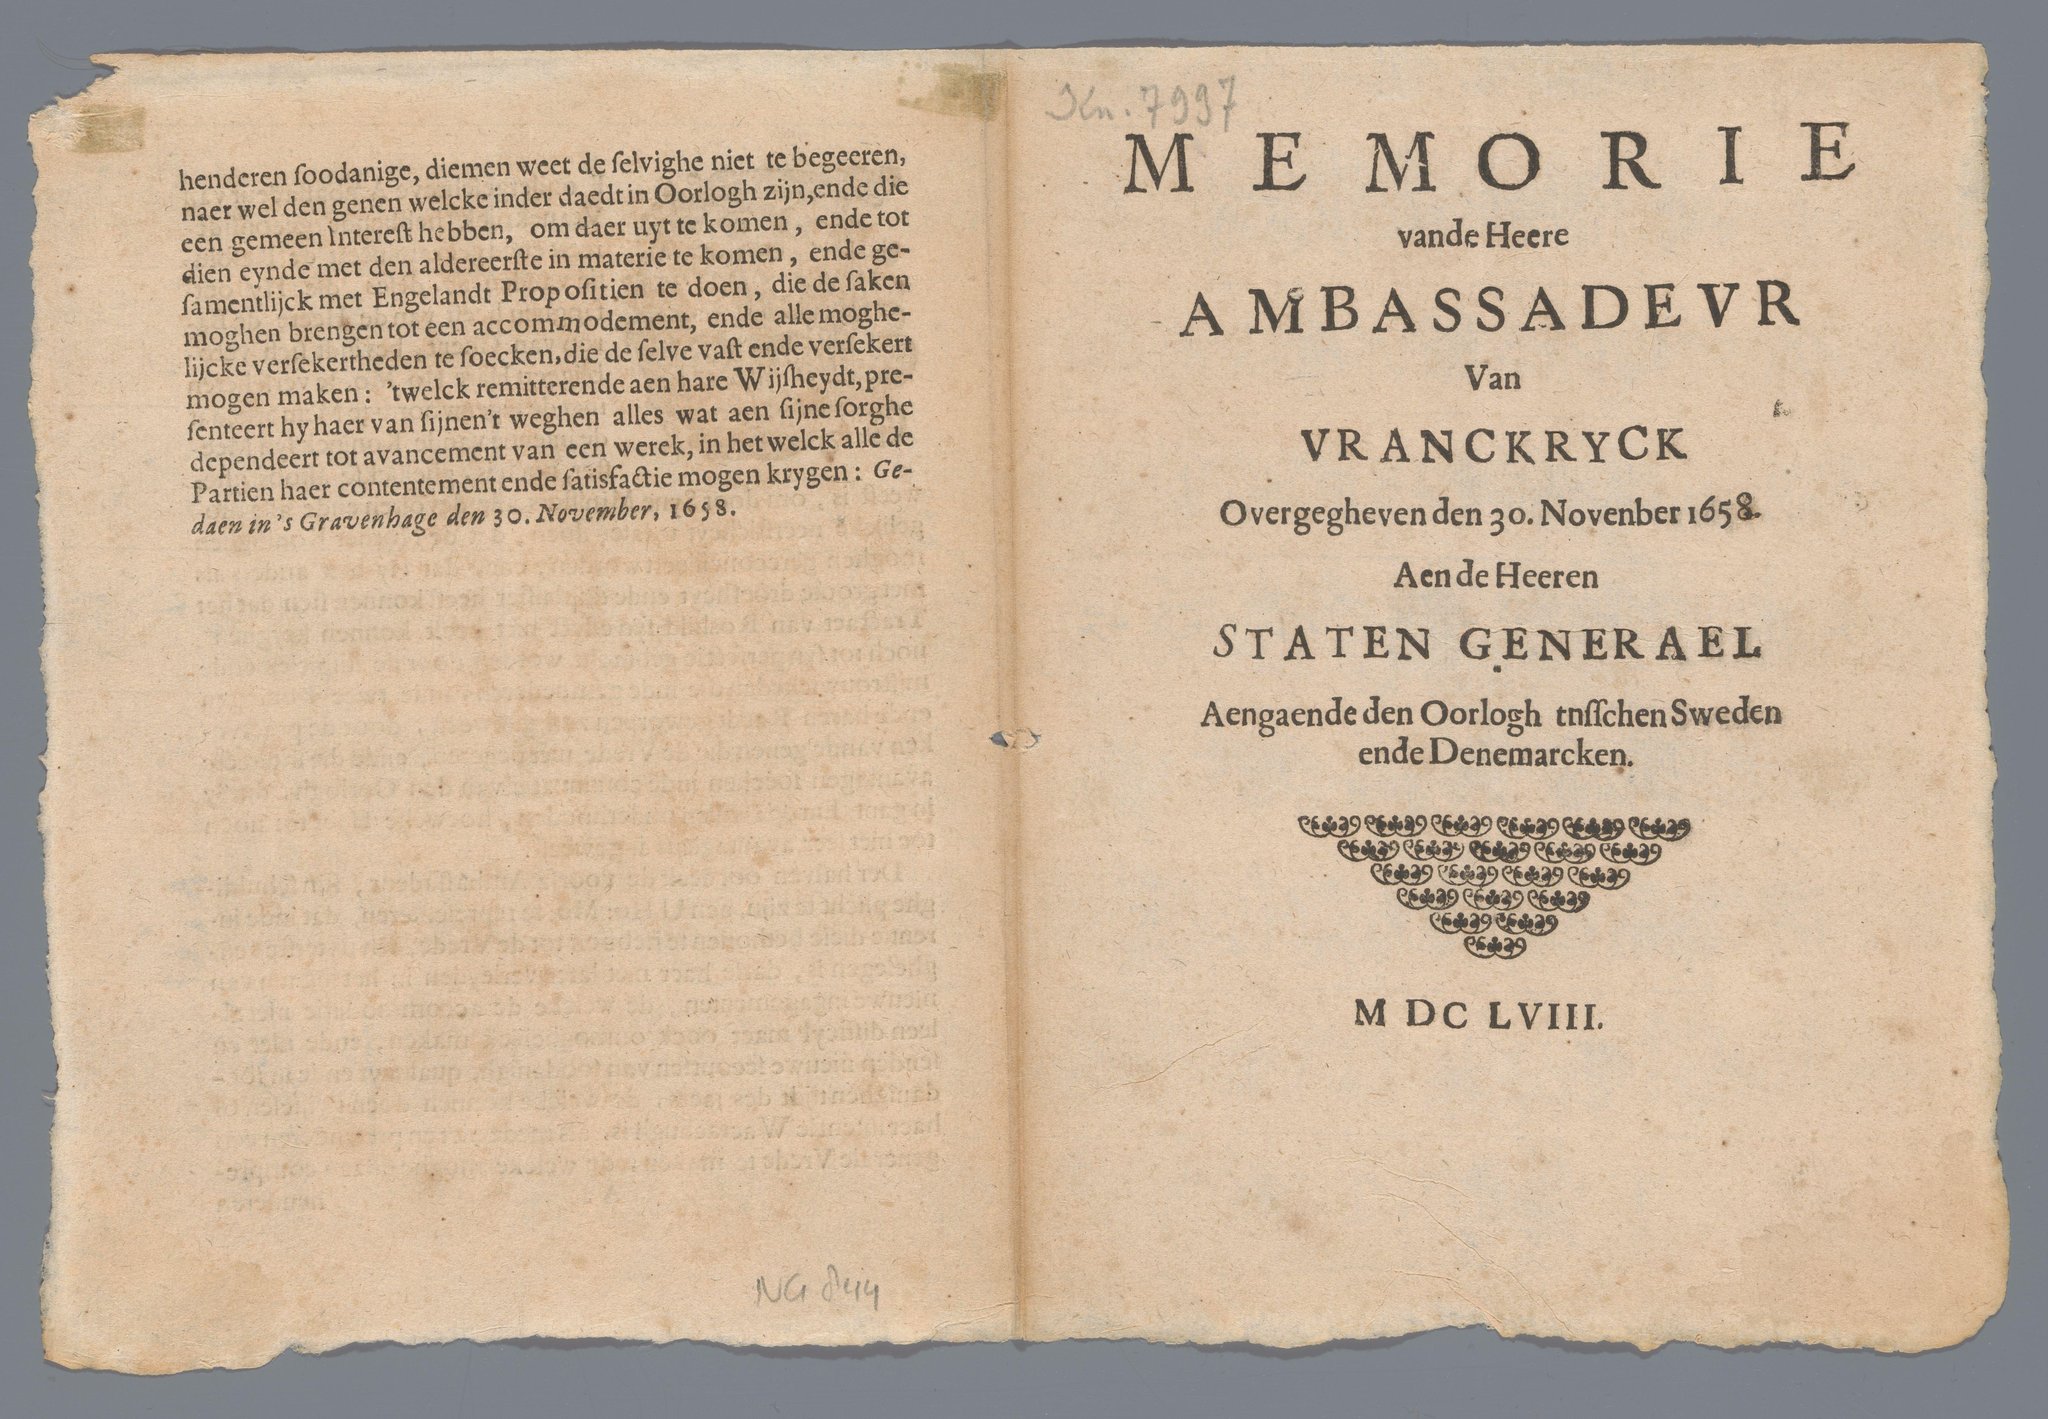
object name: pamphlet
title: Memorie vande Heere ambassadeur van Vrankrijck (...) Aengaende den Oorlogh tusschen Sweden ende Denemarcken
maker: Anonymous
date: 1658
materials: paper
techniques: folding, printing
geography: netherlands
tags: france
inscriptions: date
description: Memorie van de Franse ambassadeur aan de Staten-Generaal betreffende de oorlog tussen Zweden en Denemarken.